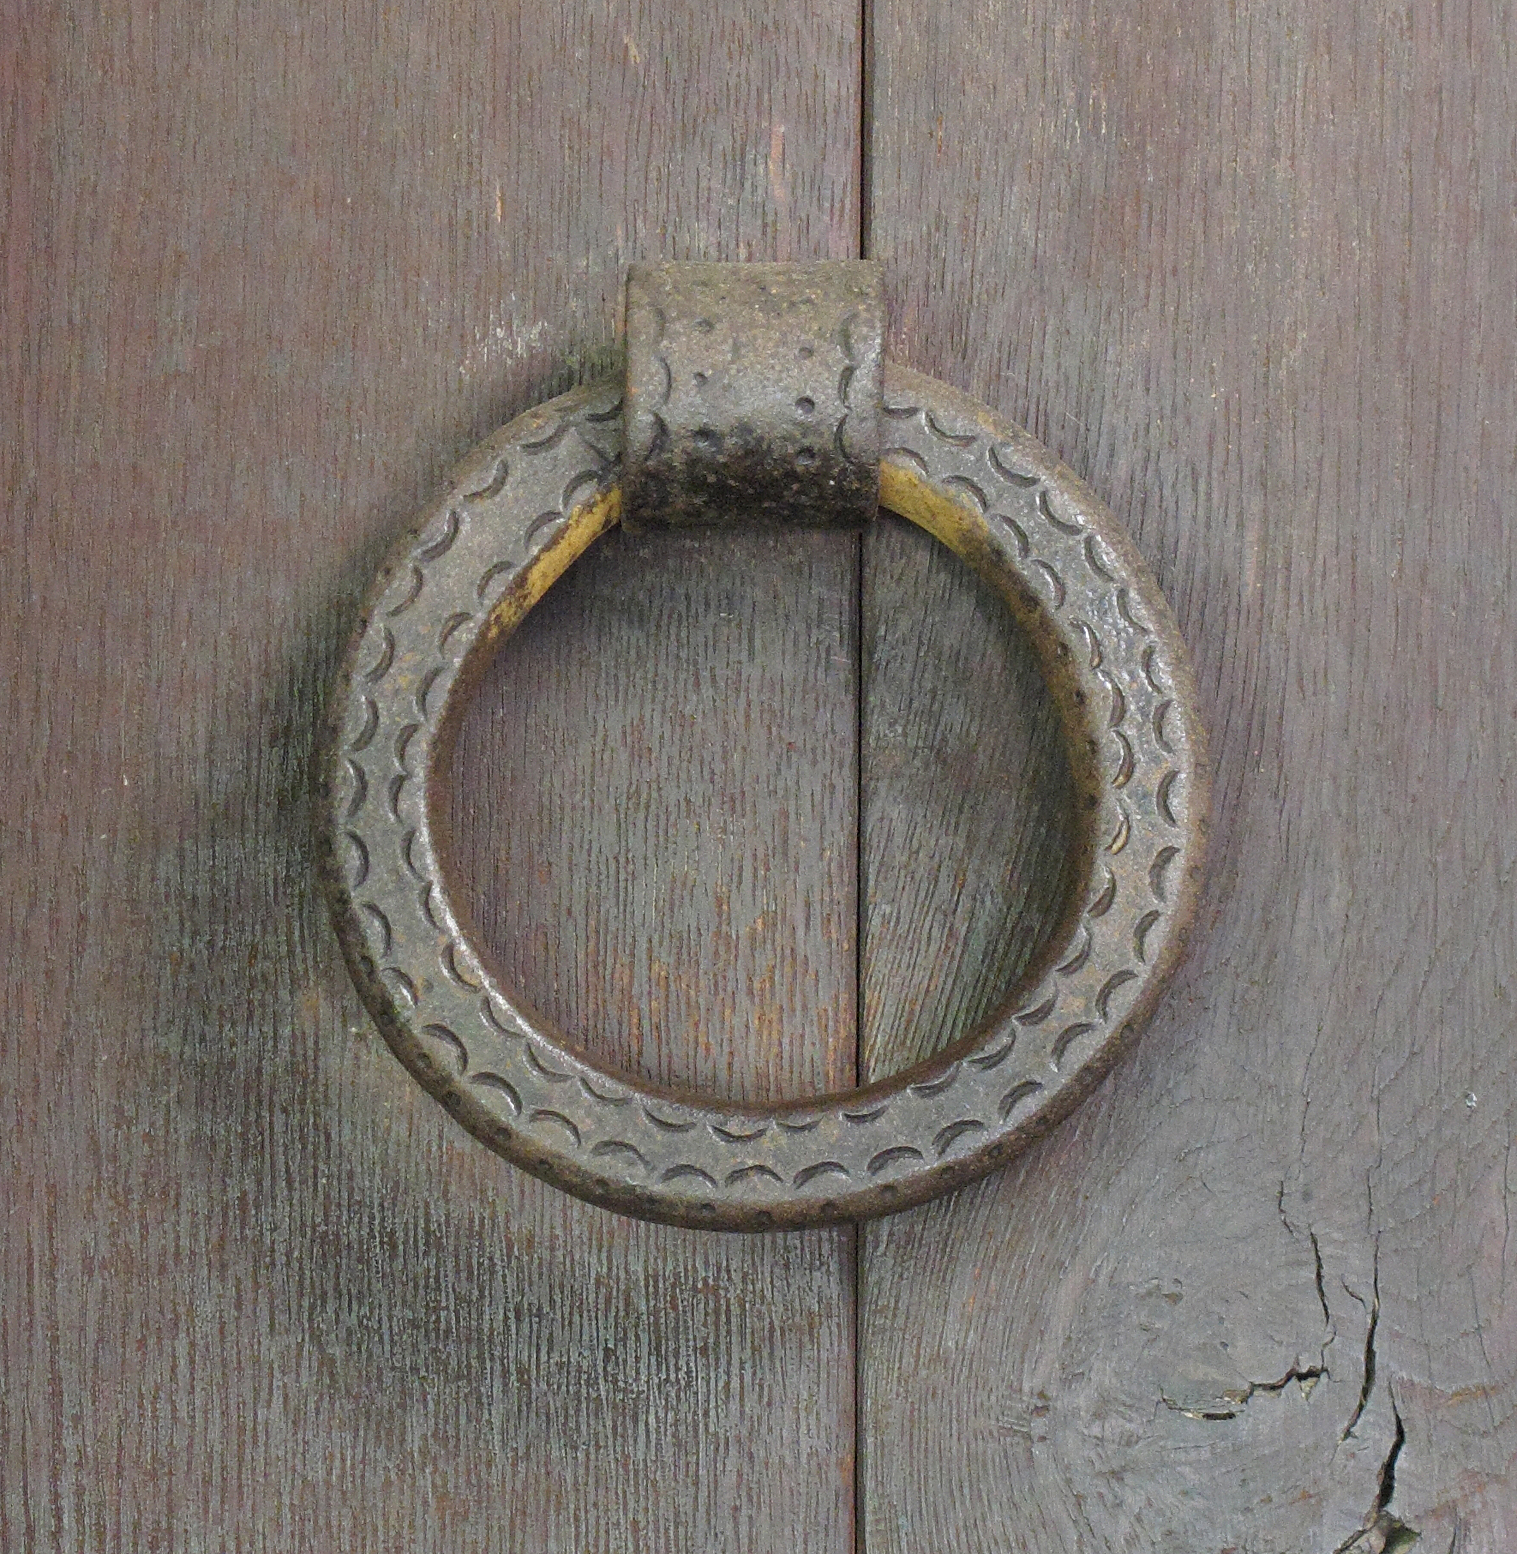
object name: door knocker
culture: european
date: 1401-1600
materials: iron